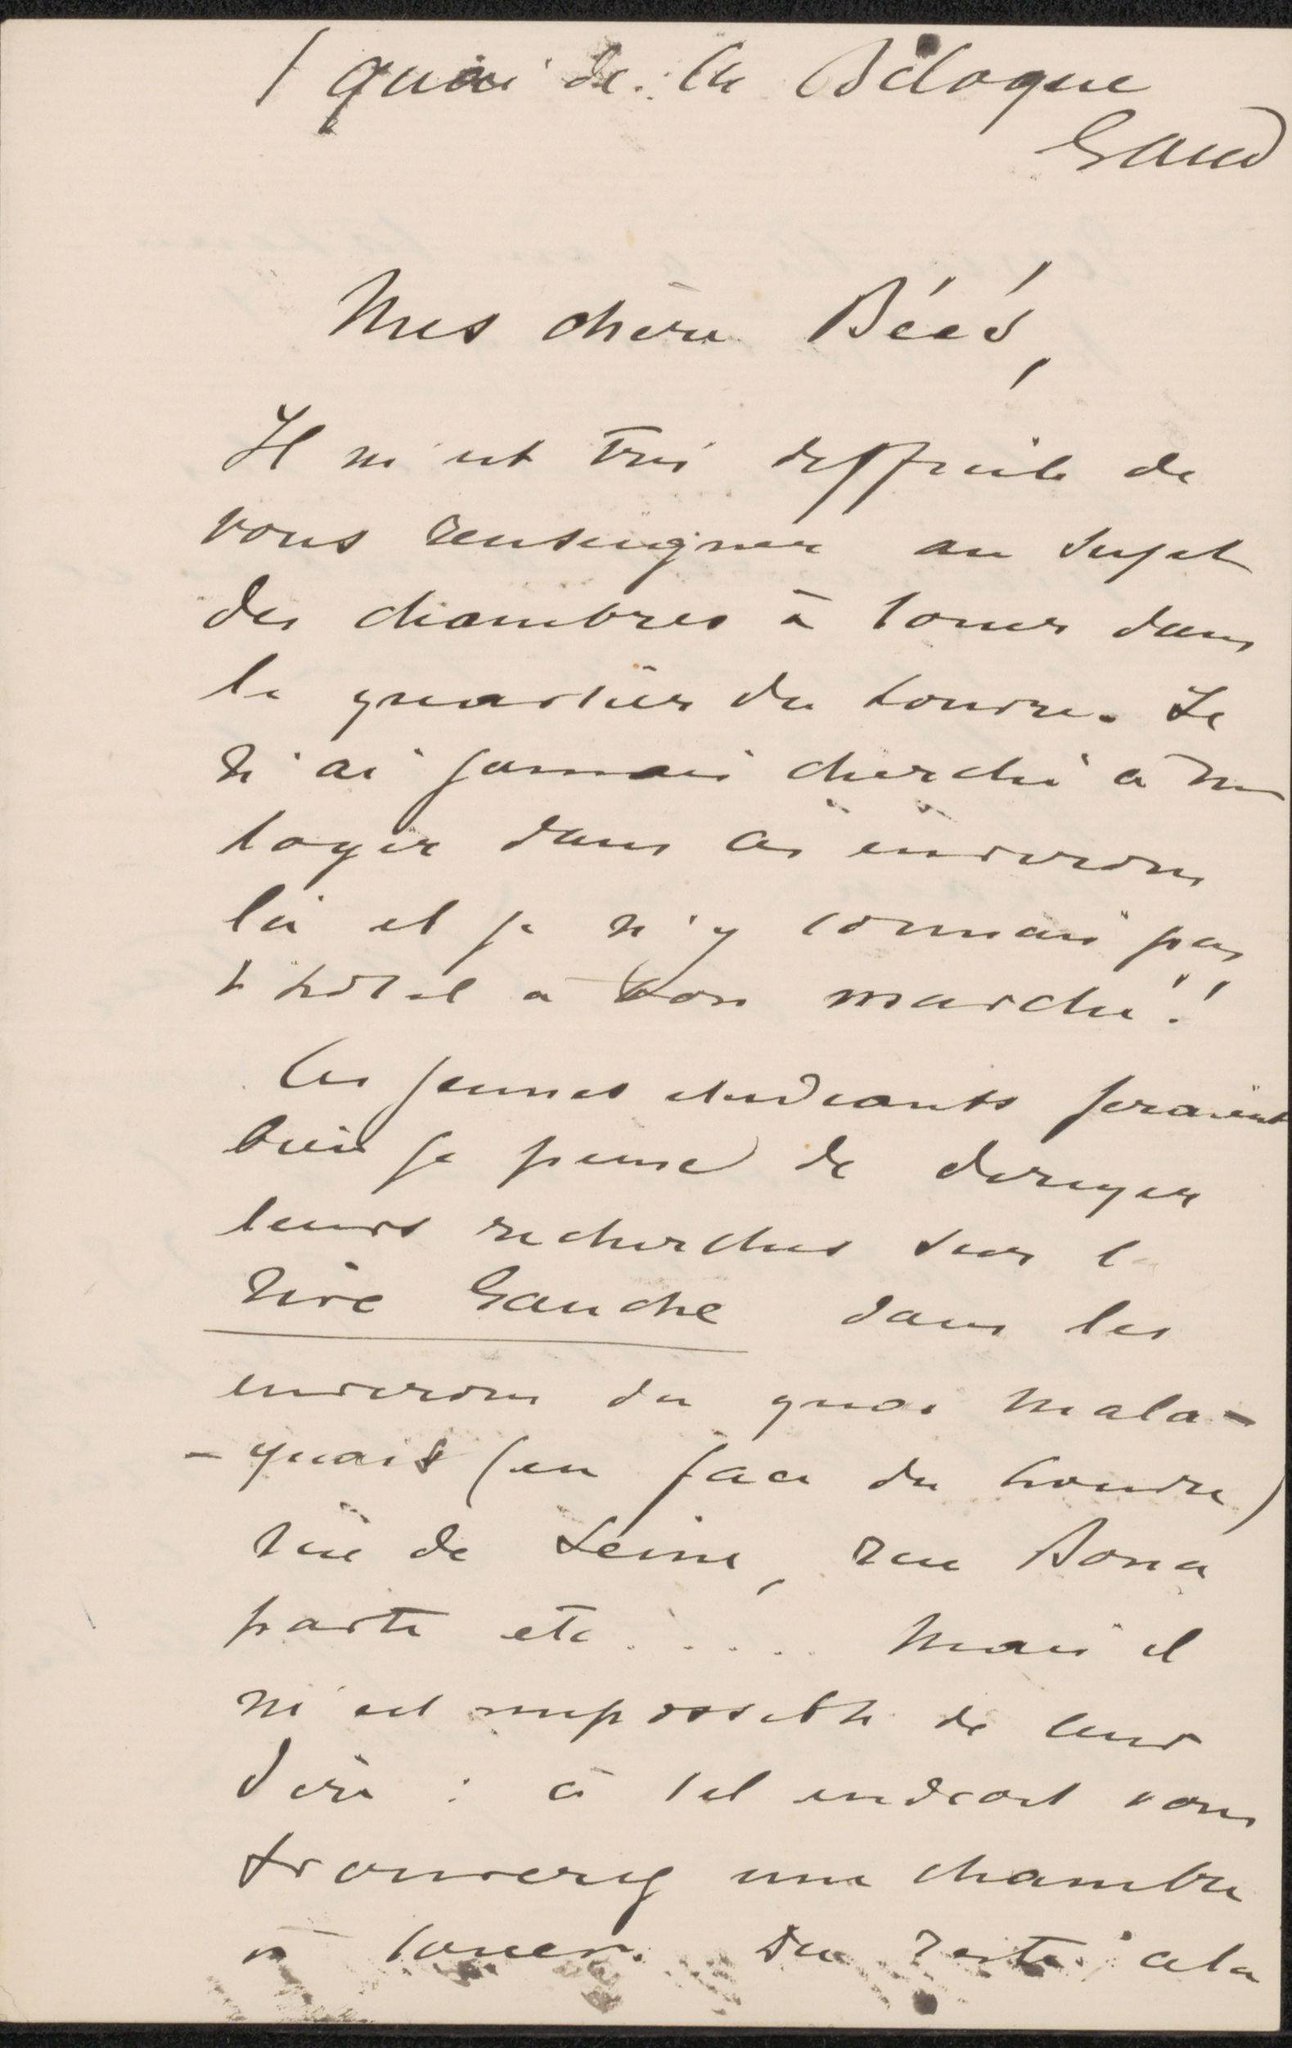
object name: letter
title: Brief aan onbekend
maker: albert baertsoen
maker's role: draughtsman, print maker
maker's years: 1866-1922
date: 1876-1922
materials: ink, paper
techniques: pen, writing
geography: ghent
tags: the hague, painter, print maker, draughtsman, hendrik willem mesdag, painting (including book-illumination, miniature-painting), exhibition ~ art, ghent, paris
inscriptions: watermark